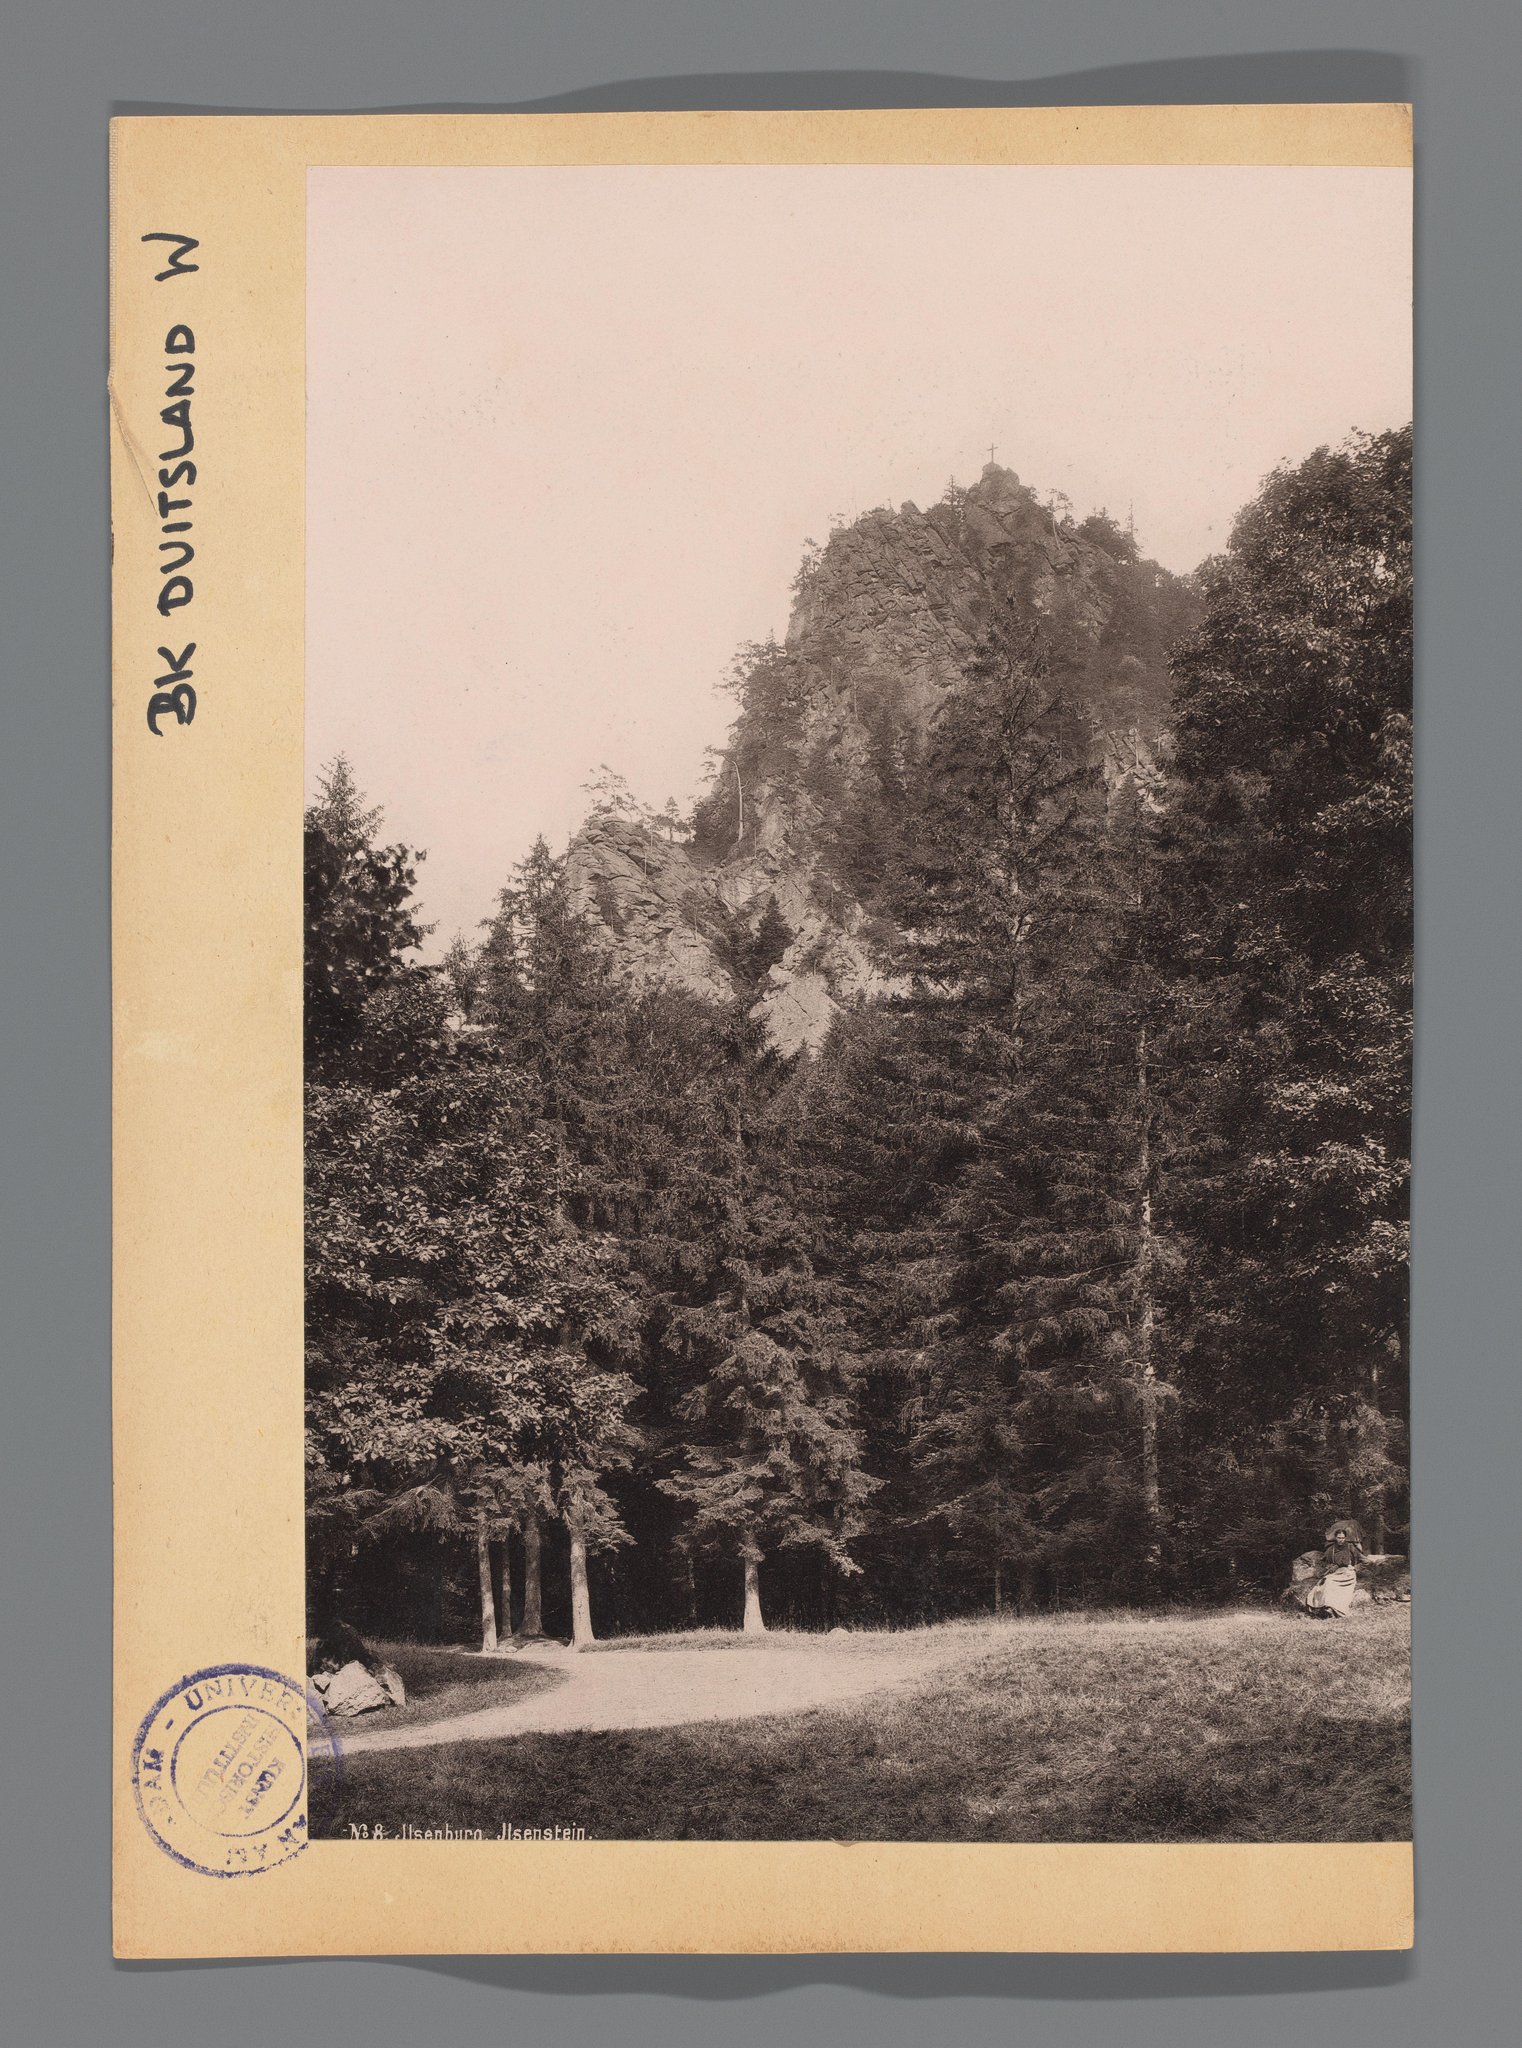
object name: photograph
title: IJsenburg, IJsenstein, Schloss Wernigerode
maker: Anonymous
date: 1880-1920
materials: cardboard, photographic support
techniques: photograph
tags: germany